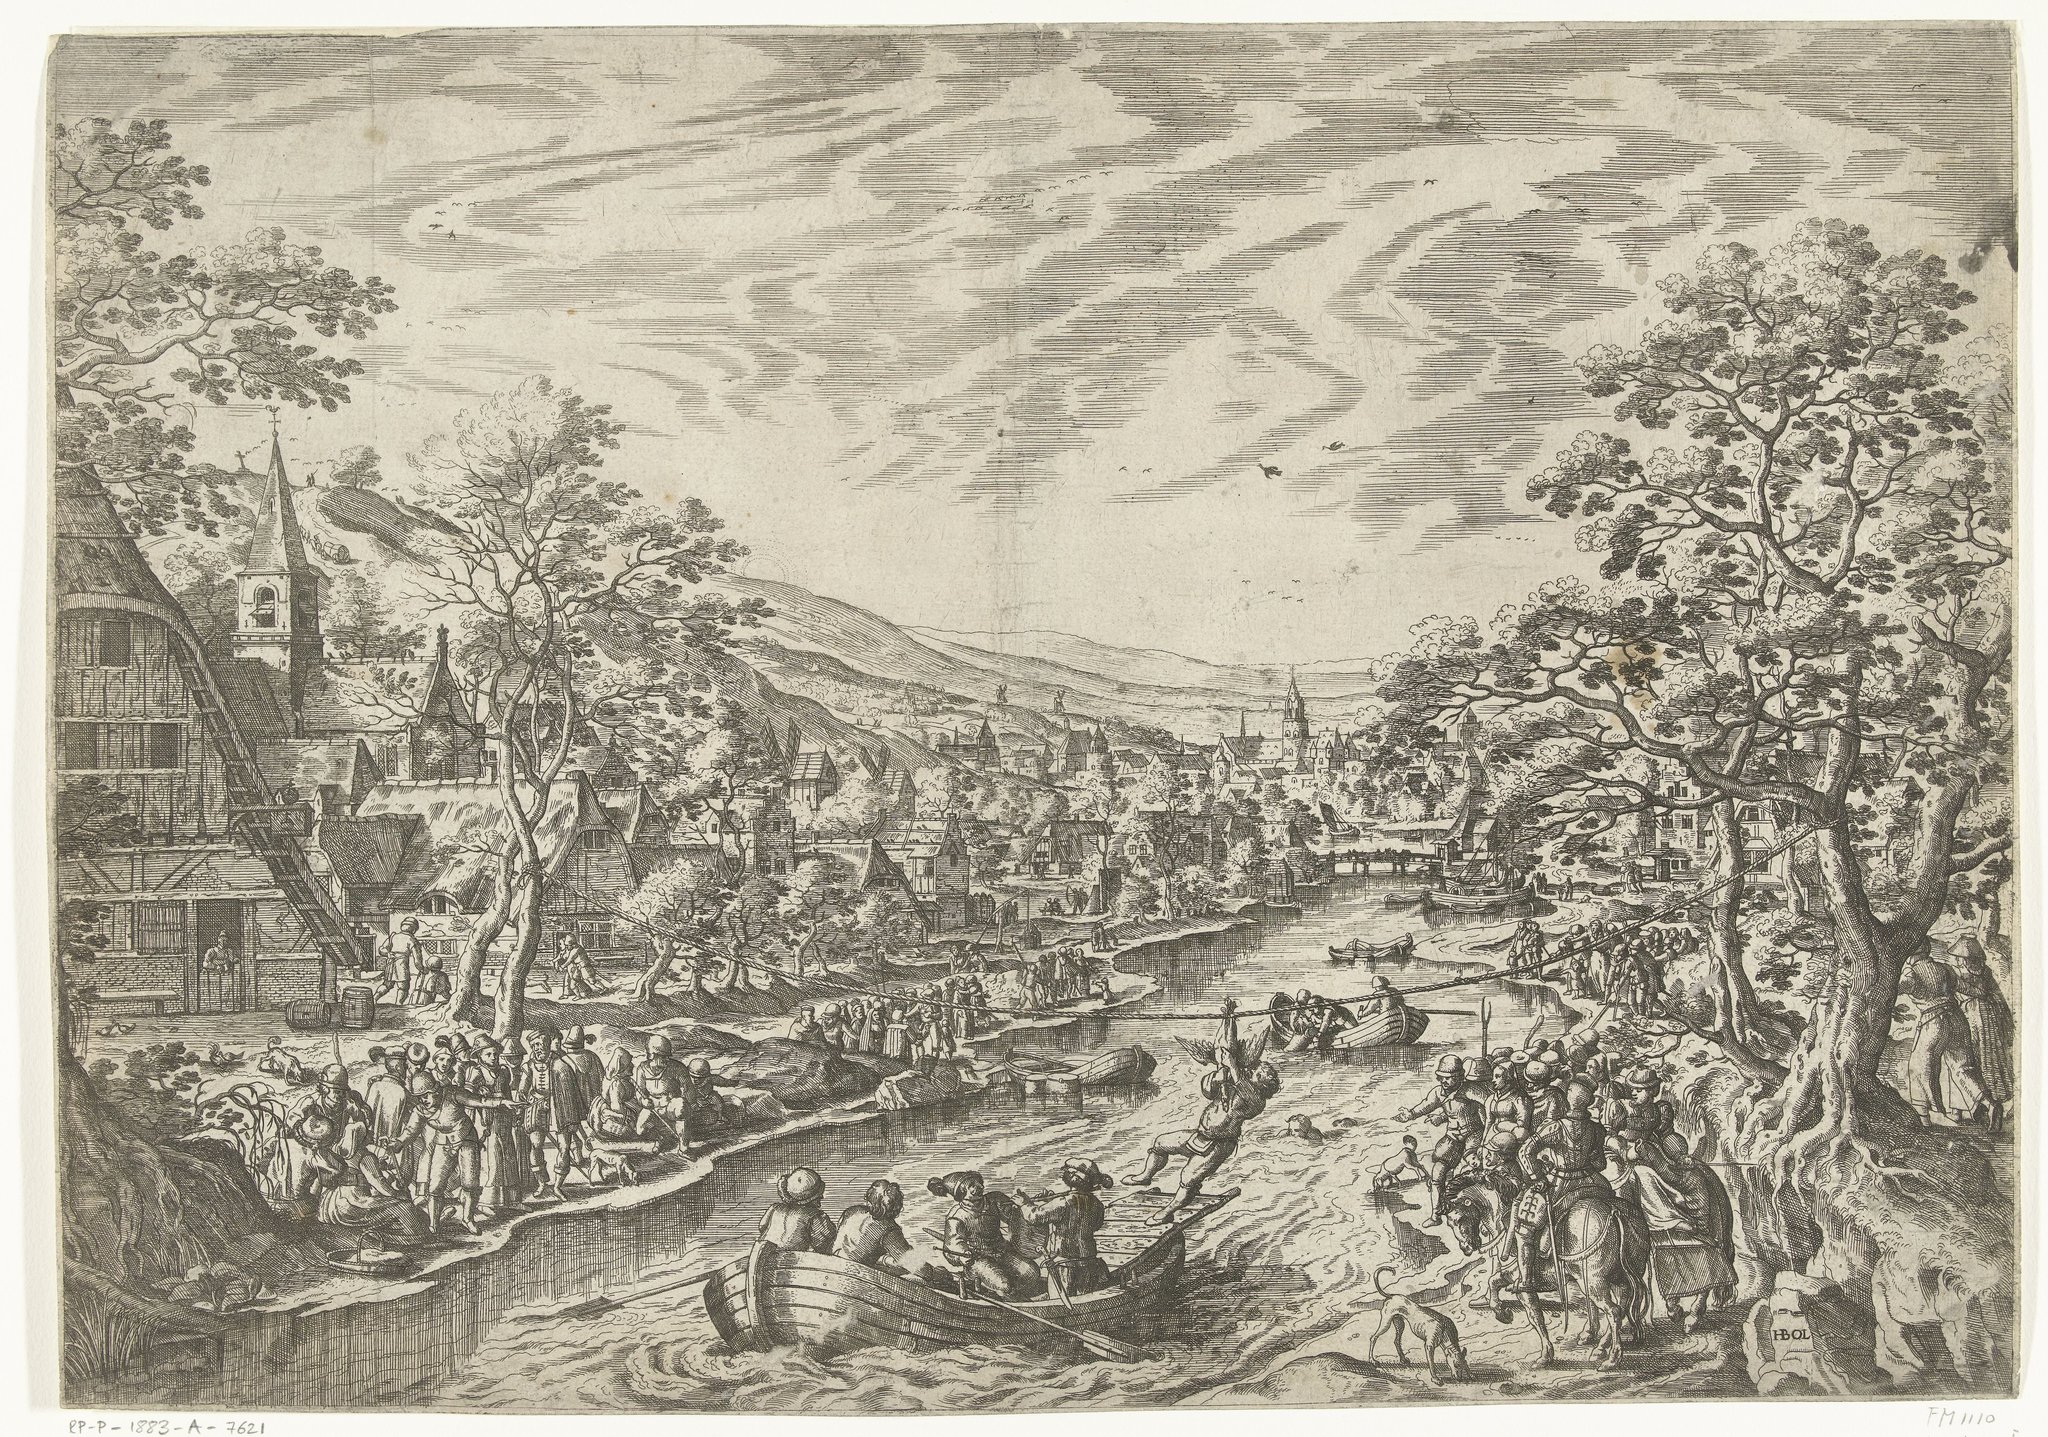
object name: print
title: Het trekken om de gans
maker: hans bol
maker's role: draughtsman, print maker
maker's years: 1534-1593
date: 1550-1593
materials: paper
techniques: etching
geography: southern netherlands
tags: 'pull-the-goose'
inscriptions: collector's mark: Lugt 2228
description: Bij een rivier vindt een feest plaats. Een bootje roeit onder een lijn door waaraan een gans hangt; een jongen probeert staande op de boot de gans er af te trekken. Langs de rivier staan mensen naar het spel te kijken.